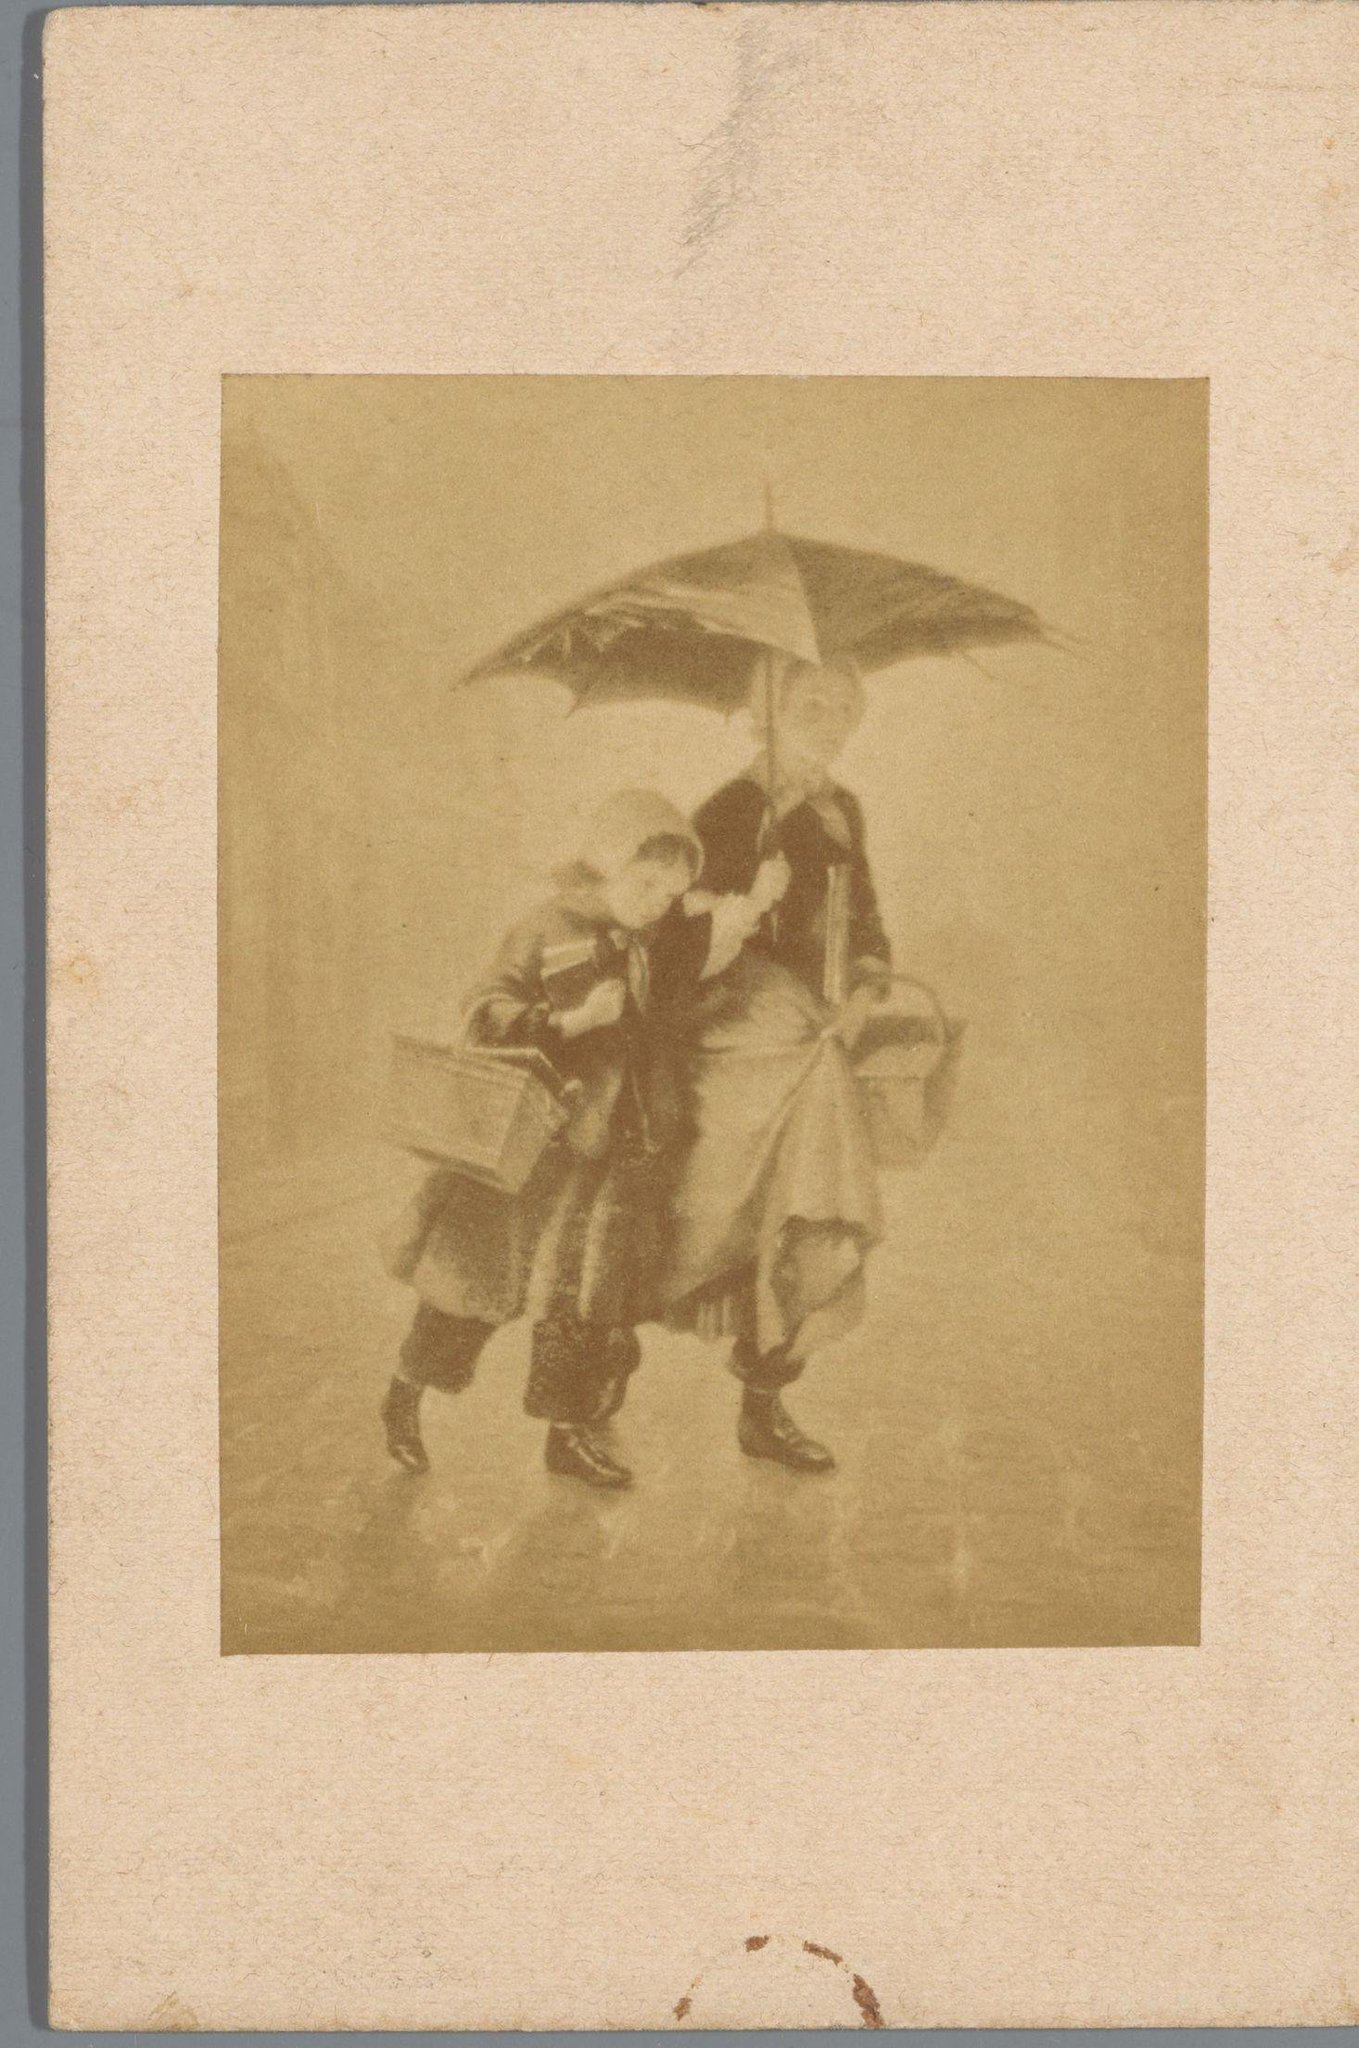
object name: photograph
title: Fotoreproductie van een schilderij naar het gedicht Naar school! door J.J.L. ten Kate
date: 1850-1900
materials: cardboard, photographic support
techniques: albumen print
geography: amsterdam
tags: downpour, rain shower, umbrella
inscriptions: inscription: ‘NAAR SCHOOL!/ (...) leven leeren./ J. J. L. TEN KATE.’